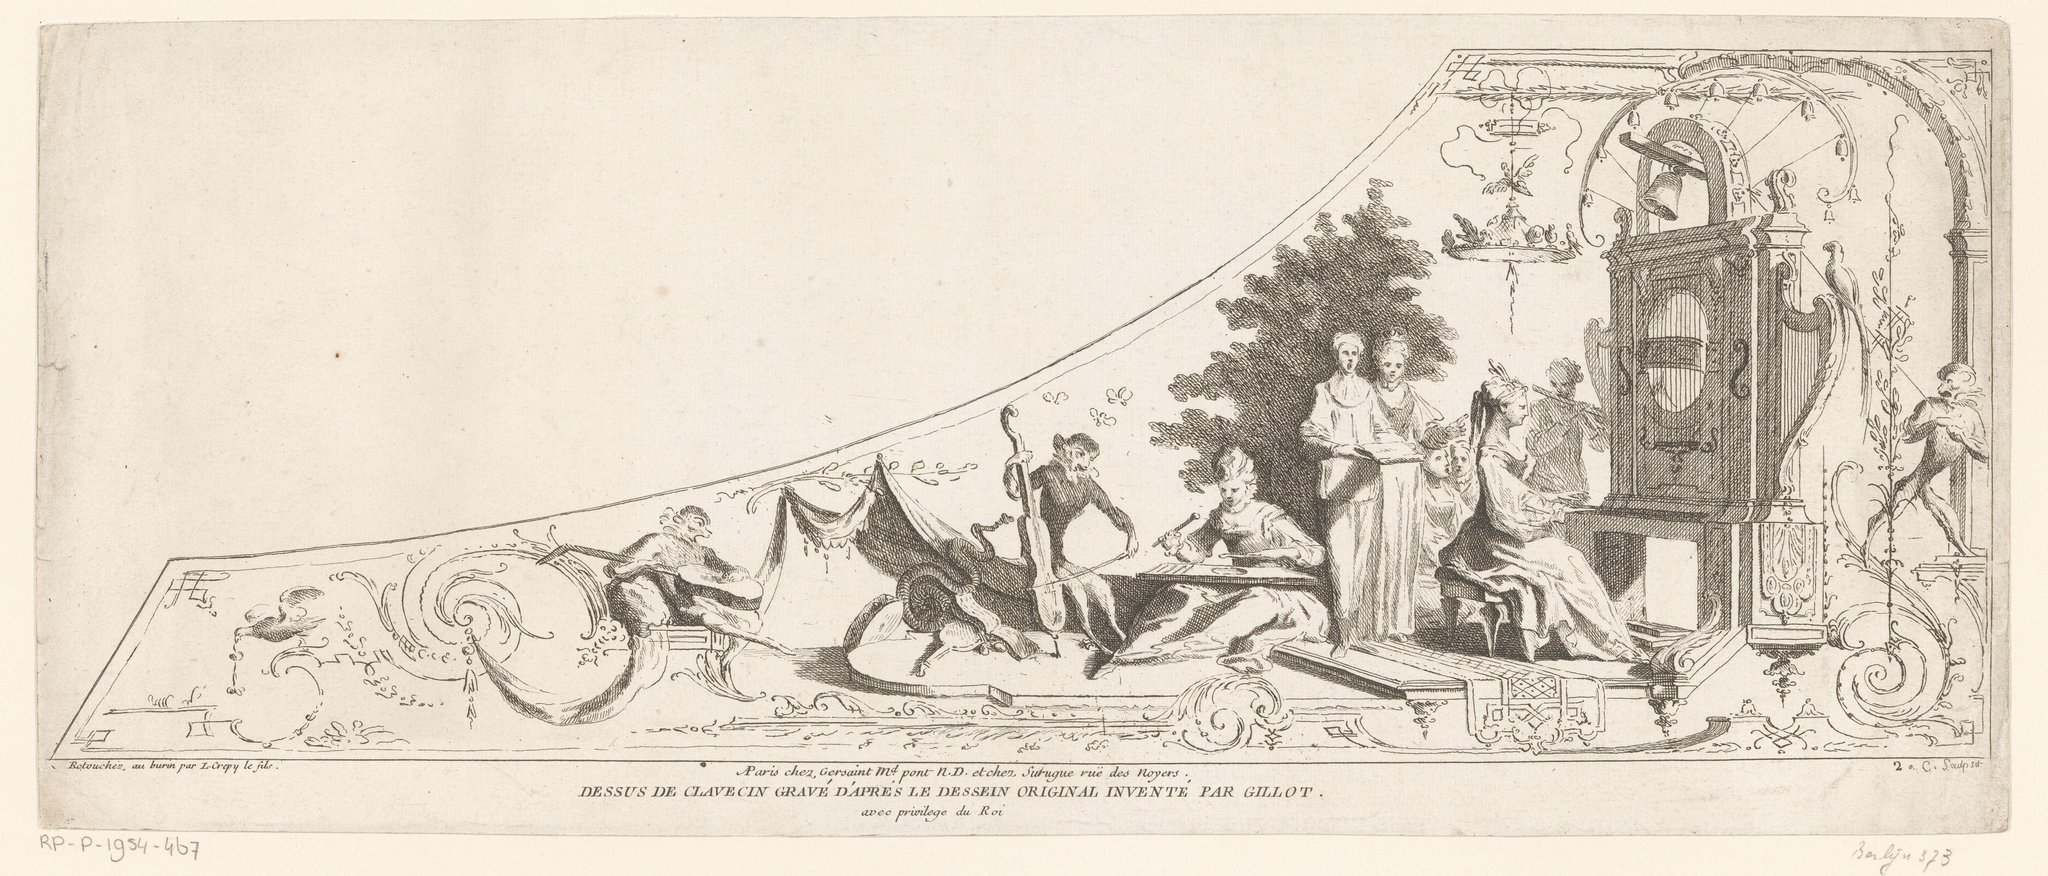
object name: ornament print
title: Klavecimbeldeksel met muzikanten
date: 1728-1740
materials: paper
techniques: etching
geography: paris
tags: making music; musician with instrument, clavichord, harpsichord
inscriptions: collector's mark: Lugt 2228, collector's mark: Lugt 2760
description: Een ontwerp voor een klavecimbeldeksel met musicerende mensen en apen omgeven door arabesken. Rechts zit een vrouw achter toetsinstrument met harpen en bellen.